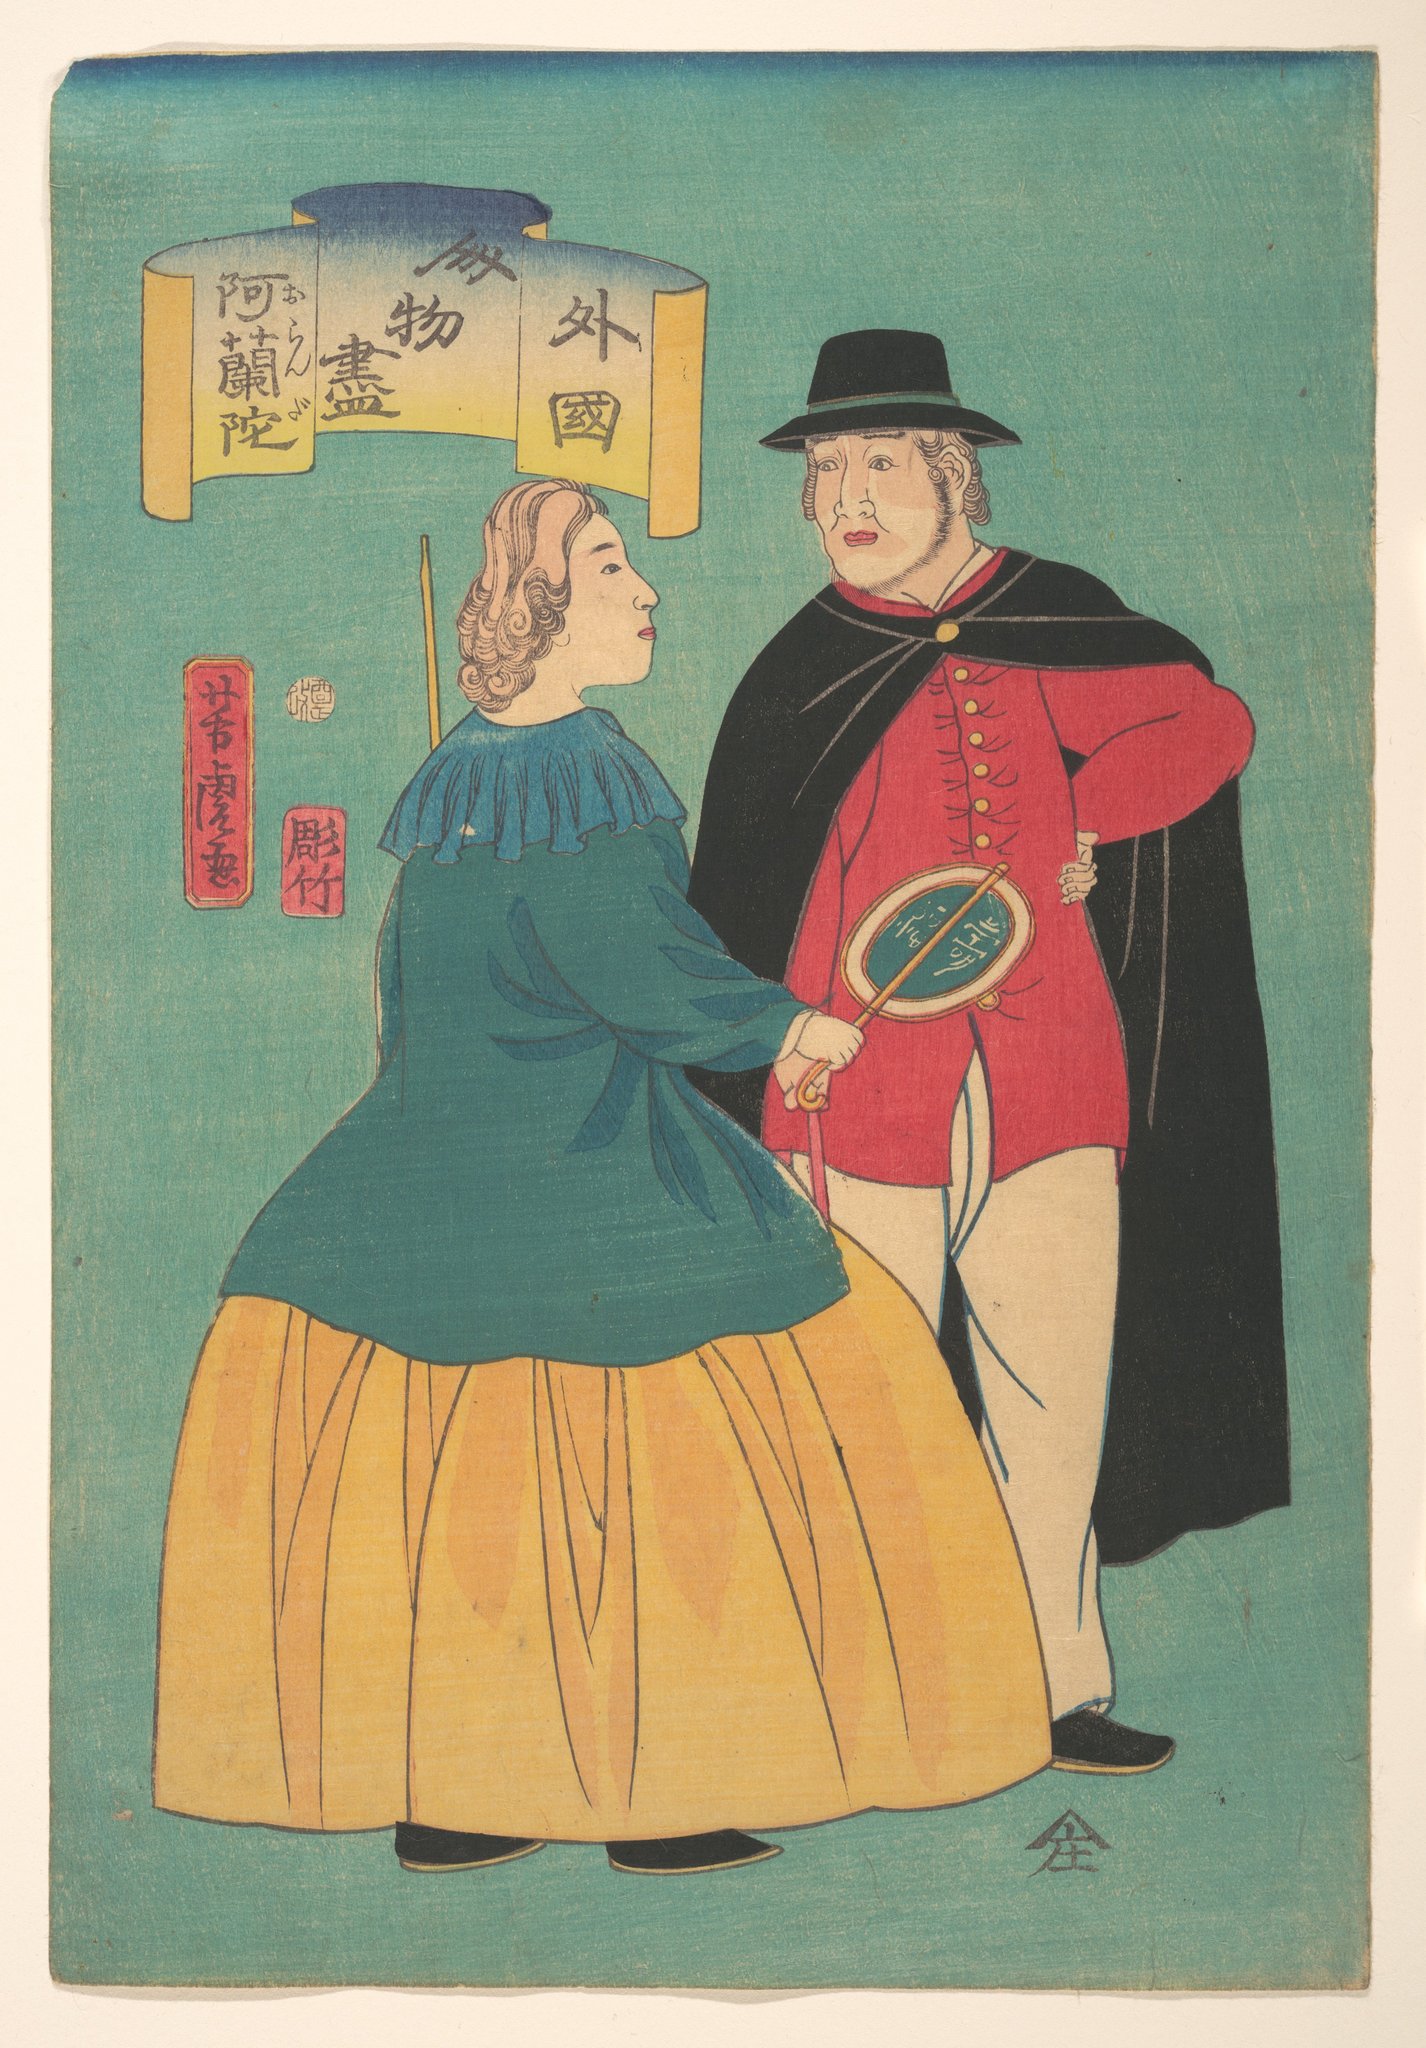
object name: print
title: Dutch Couple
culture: japanese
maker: utagawa yoshitora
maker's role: artist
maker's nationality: japanese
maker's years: 1845-1880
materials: ink, paper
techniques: woodblock print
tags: couples